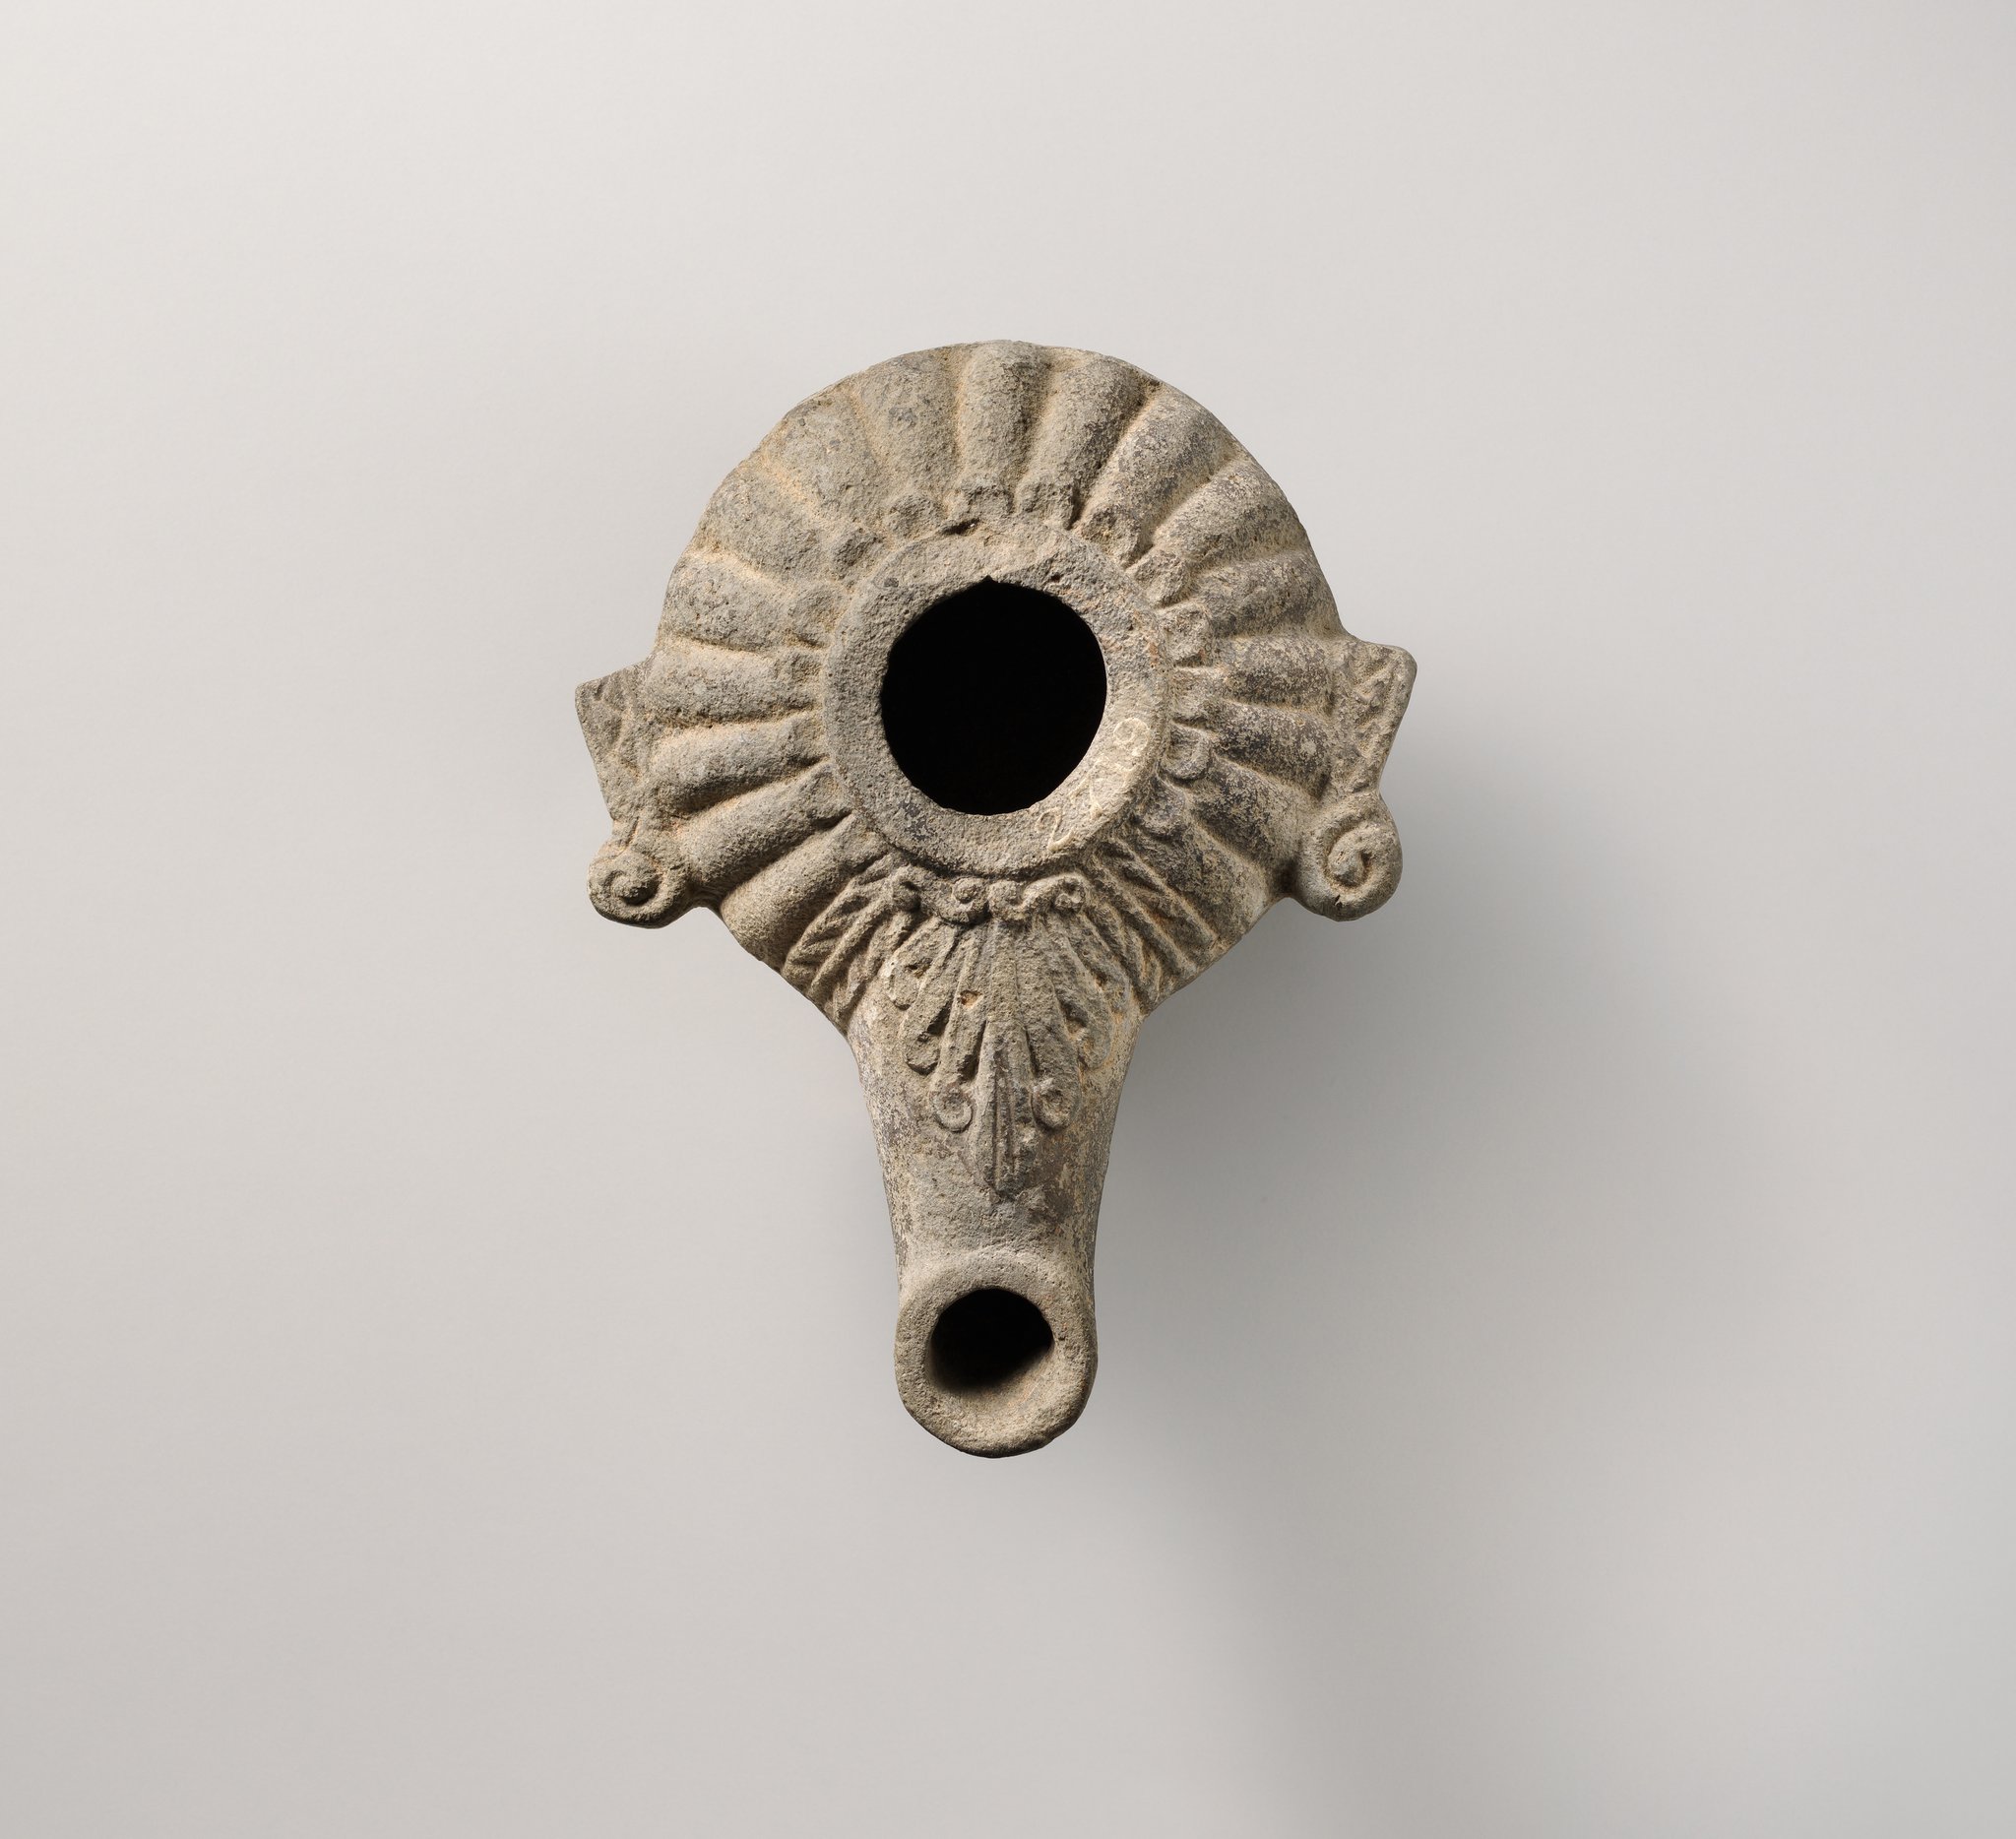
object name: lamp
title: Terrracotta oil lamp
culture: greek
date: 7000 BCE-330 CE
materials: terracotta